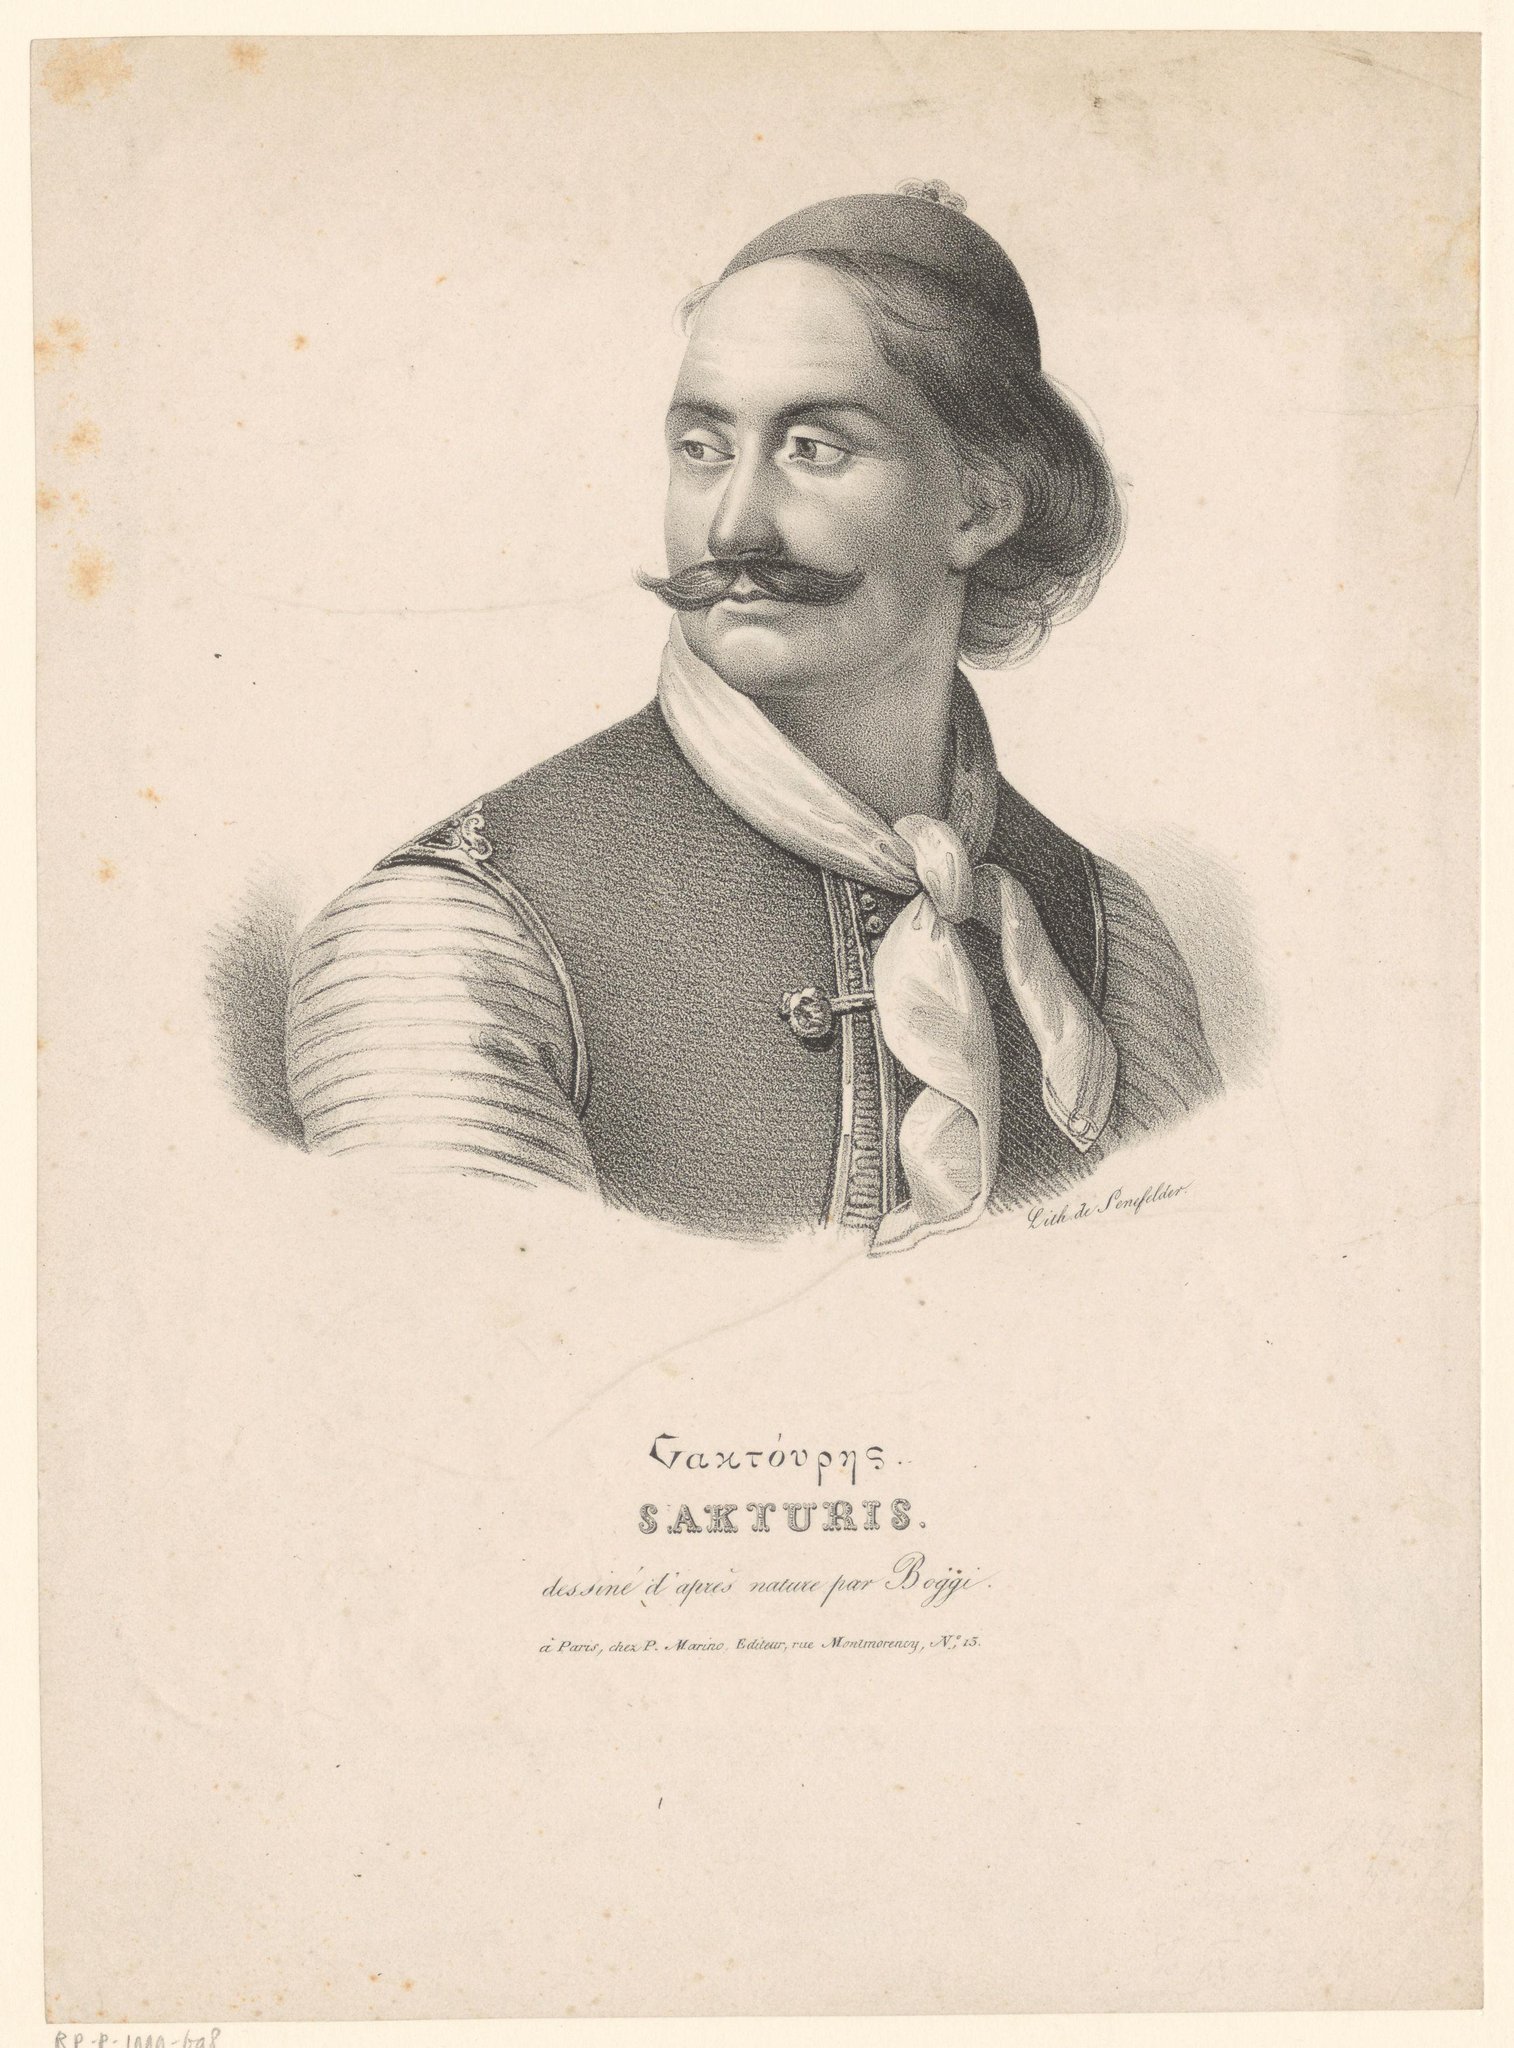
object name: print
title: Sakturis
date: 1820-1830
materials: paper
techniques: lithograph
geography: paris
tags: moustache, adult man, historical persons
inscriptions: inscription: ‘Portr. 53171; LB XX 356857’, collector's mark: Lugt 2760, collector's mark: Lugt 2228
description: Prent mogelijk uit: Collection de portraits des personnages Turcs and Grecs les plus recommes soit par leur cruate soit par leur bravoure dans la guerre actuelle de la Grece. Parijs: s.n., [1826].